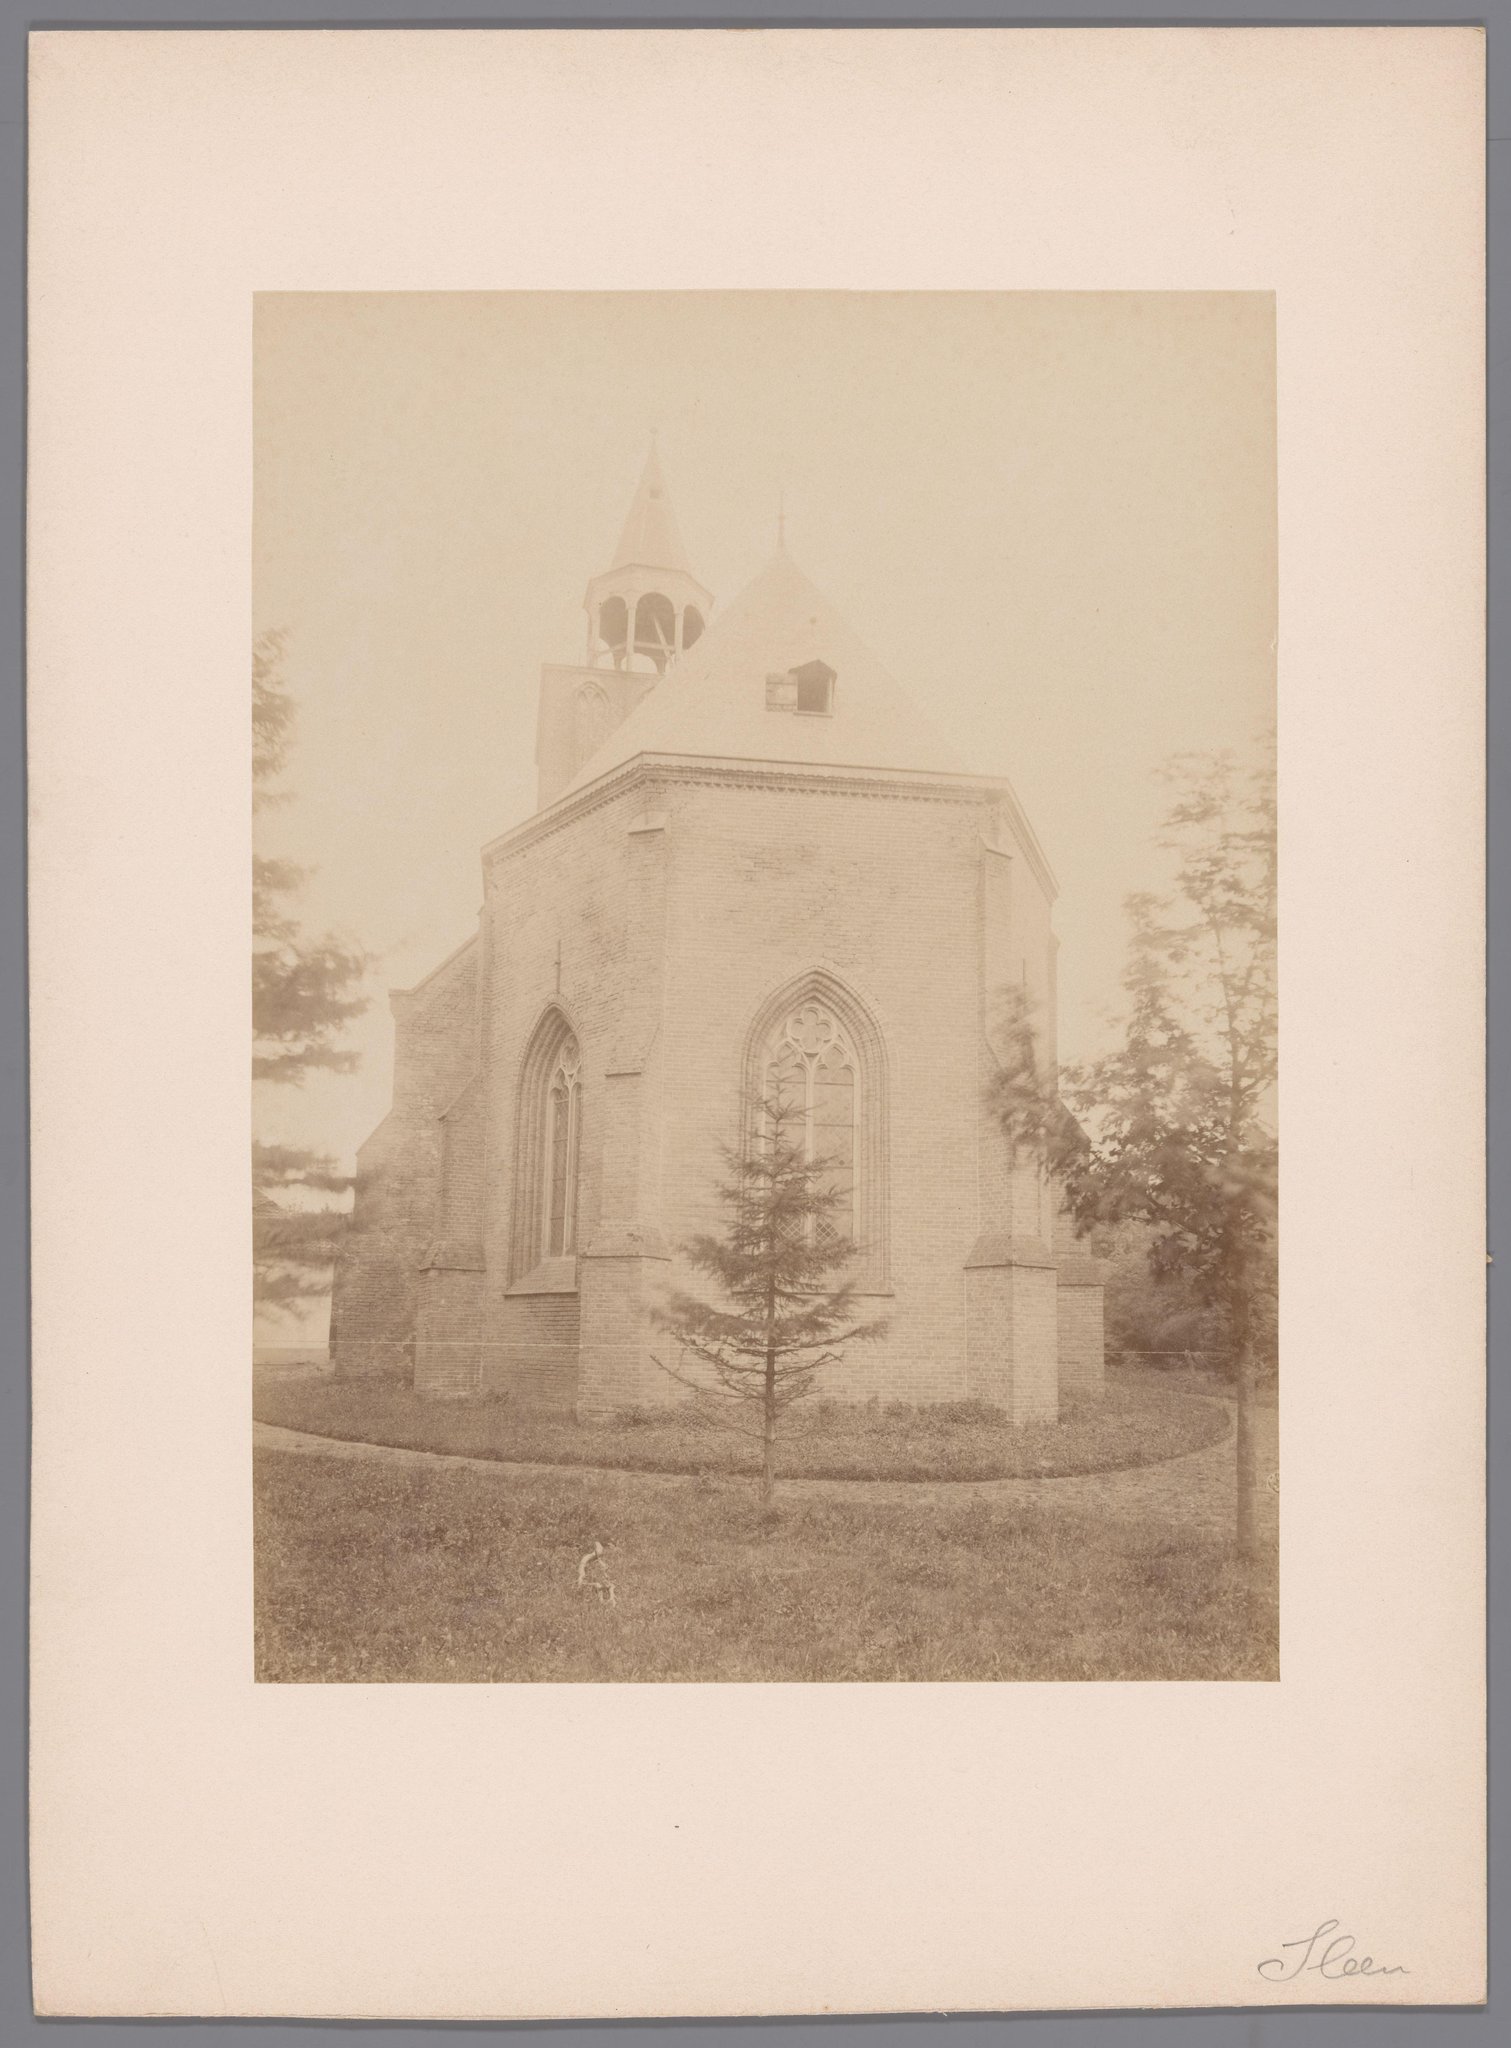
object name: photograph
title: Gezicht op de Hervormde Kerk te Sleen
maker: anoniem (monumentenzorg)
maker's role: fotograaf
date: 1903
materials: cardboard, photographic support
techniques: albumen print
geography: sleen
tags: church (exterior)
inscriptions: annotation: ‘Sleen (Drenthe)/ Kerk der N.H. gemeente/ juli 1903’, annotation: ‘Sleen’